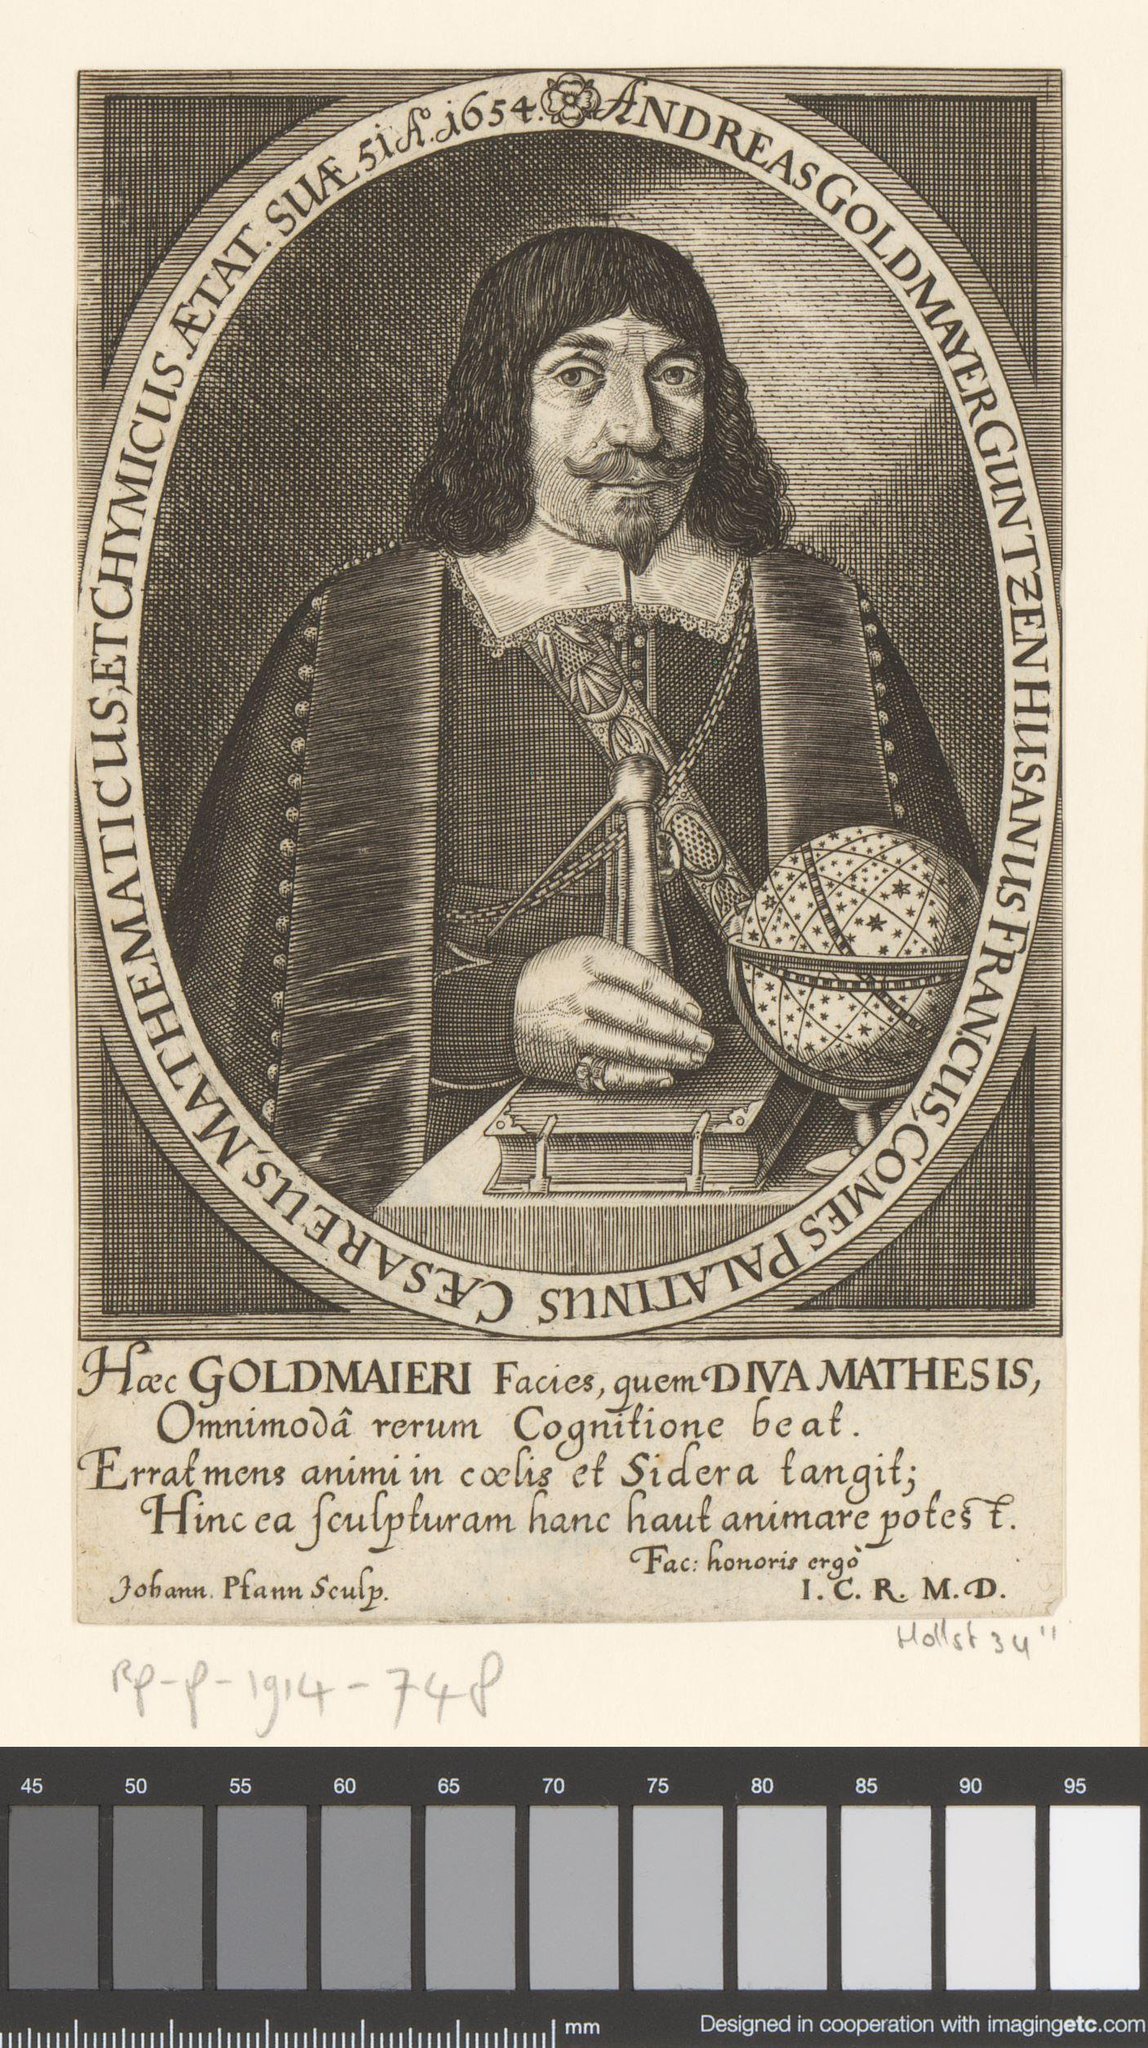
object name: print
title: Portret van Andreas Goldmayer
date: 1648-1663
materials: paper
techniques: engraving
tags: historical persons, compasses, book, globe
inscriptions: collector's mark: Lugt 2228